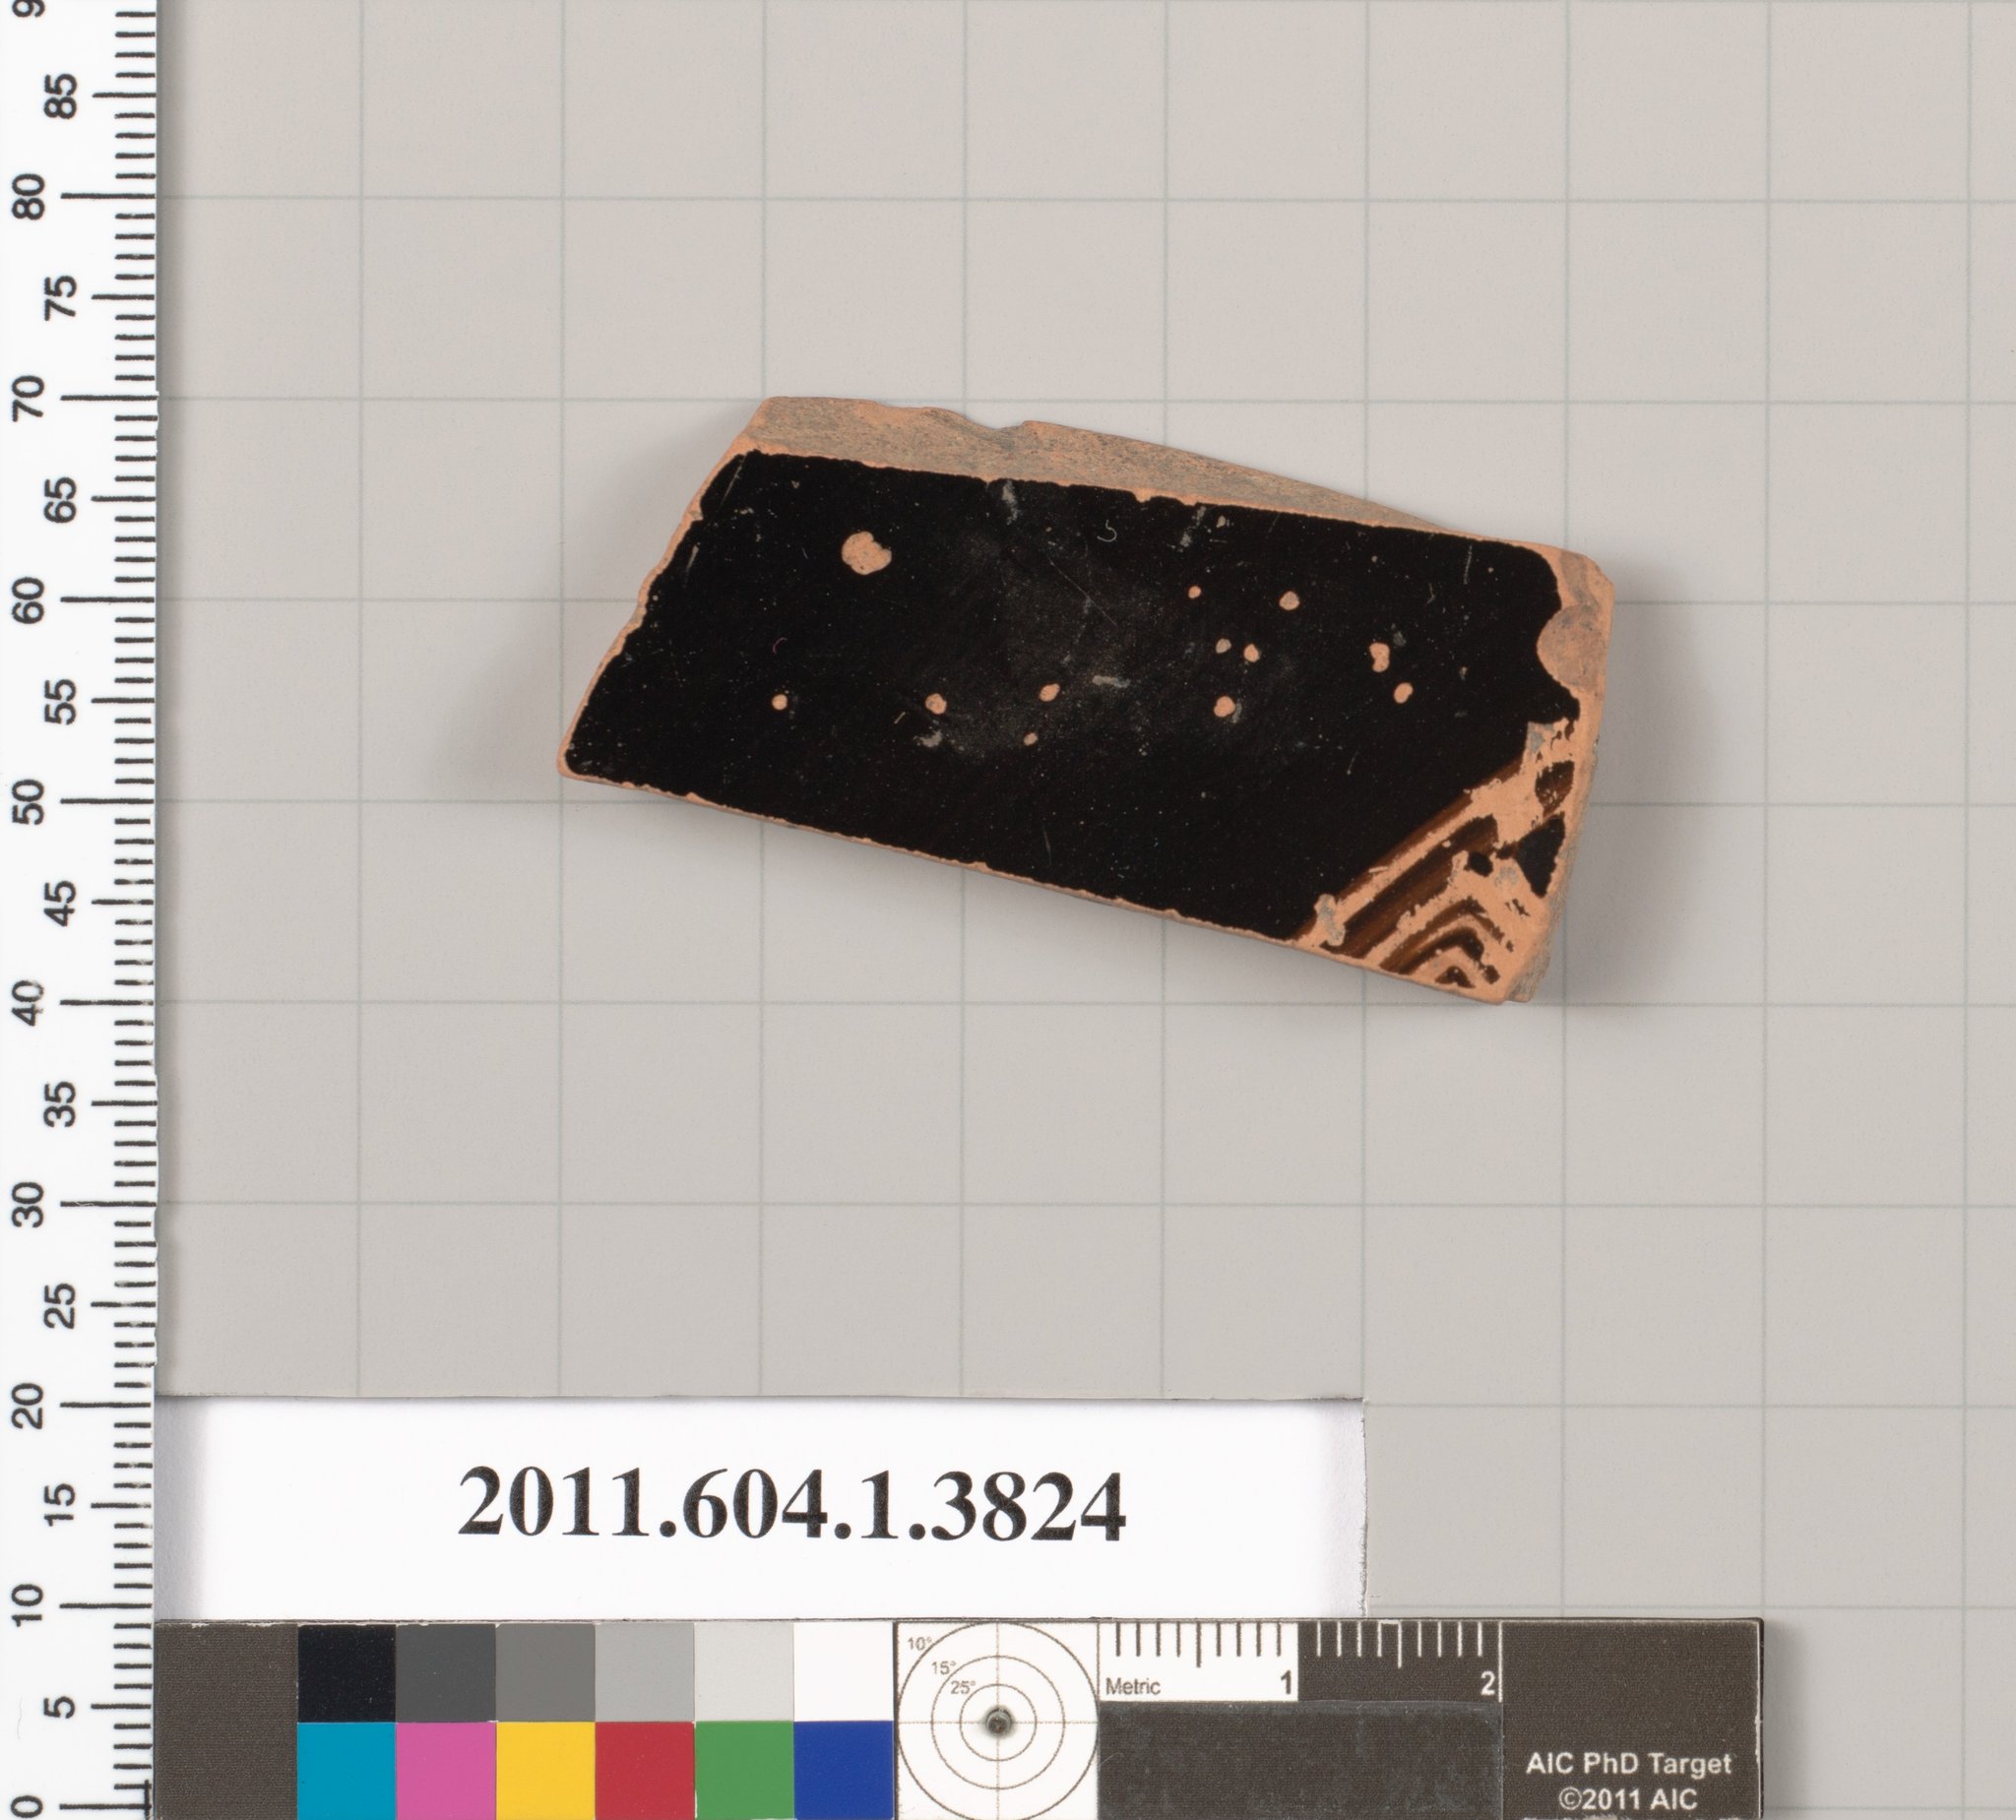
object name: kylix fragment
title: Terracotta fragment of a kylix (drinking cup)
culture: greek, attic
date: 475-451 BCE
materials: terracotta